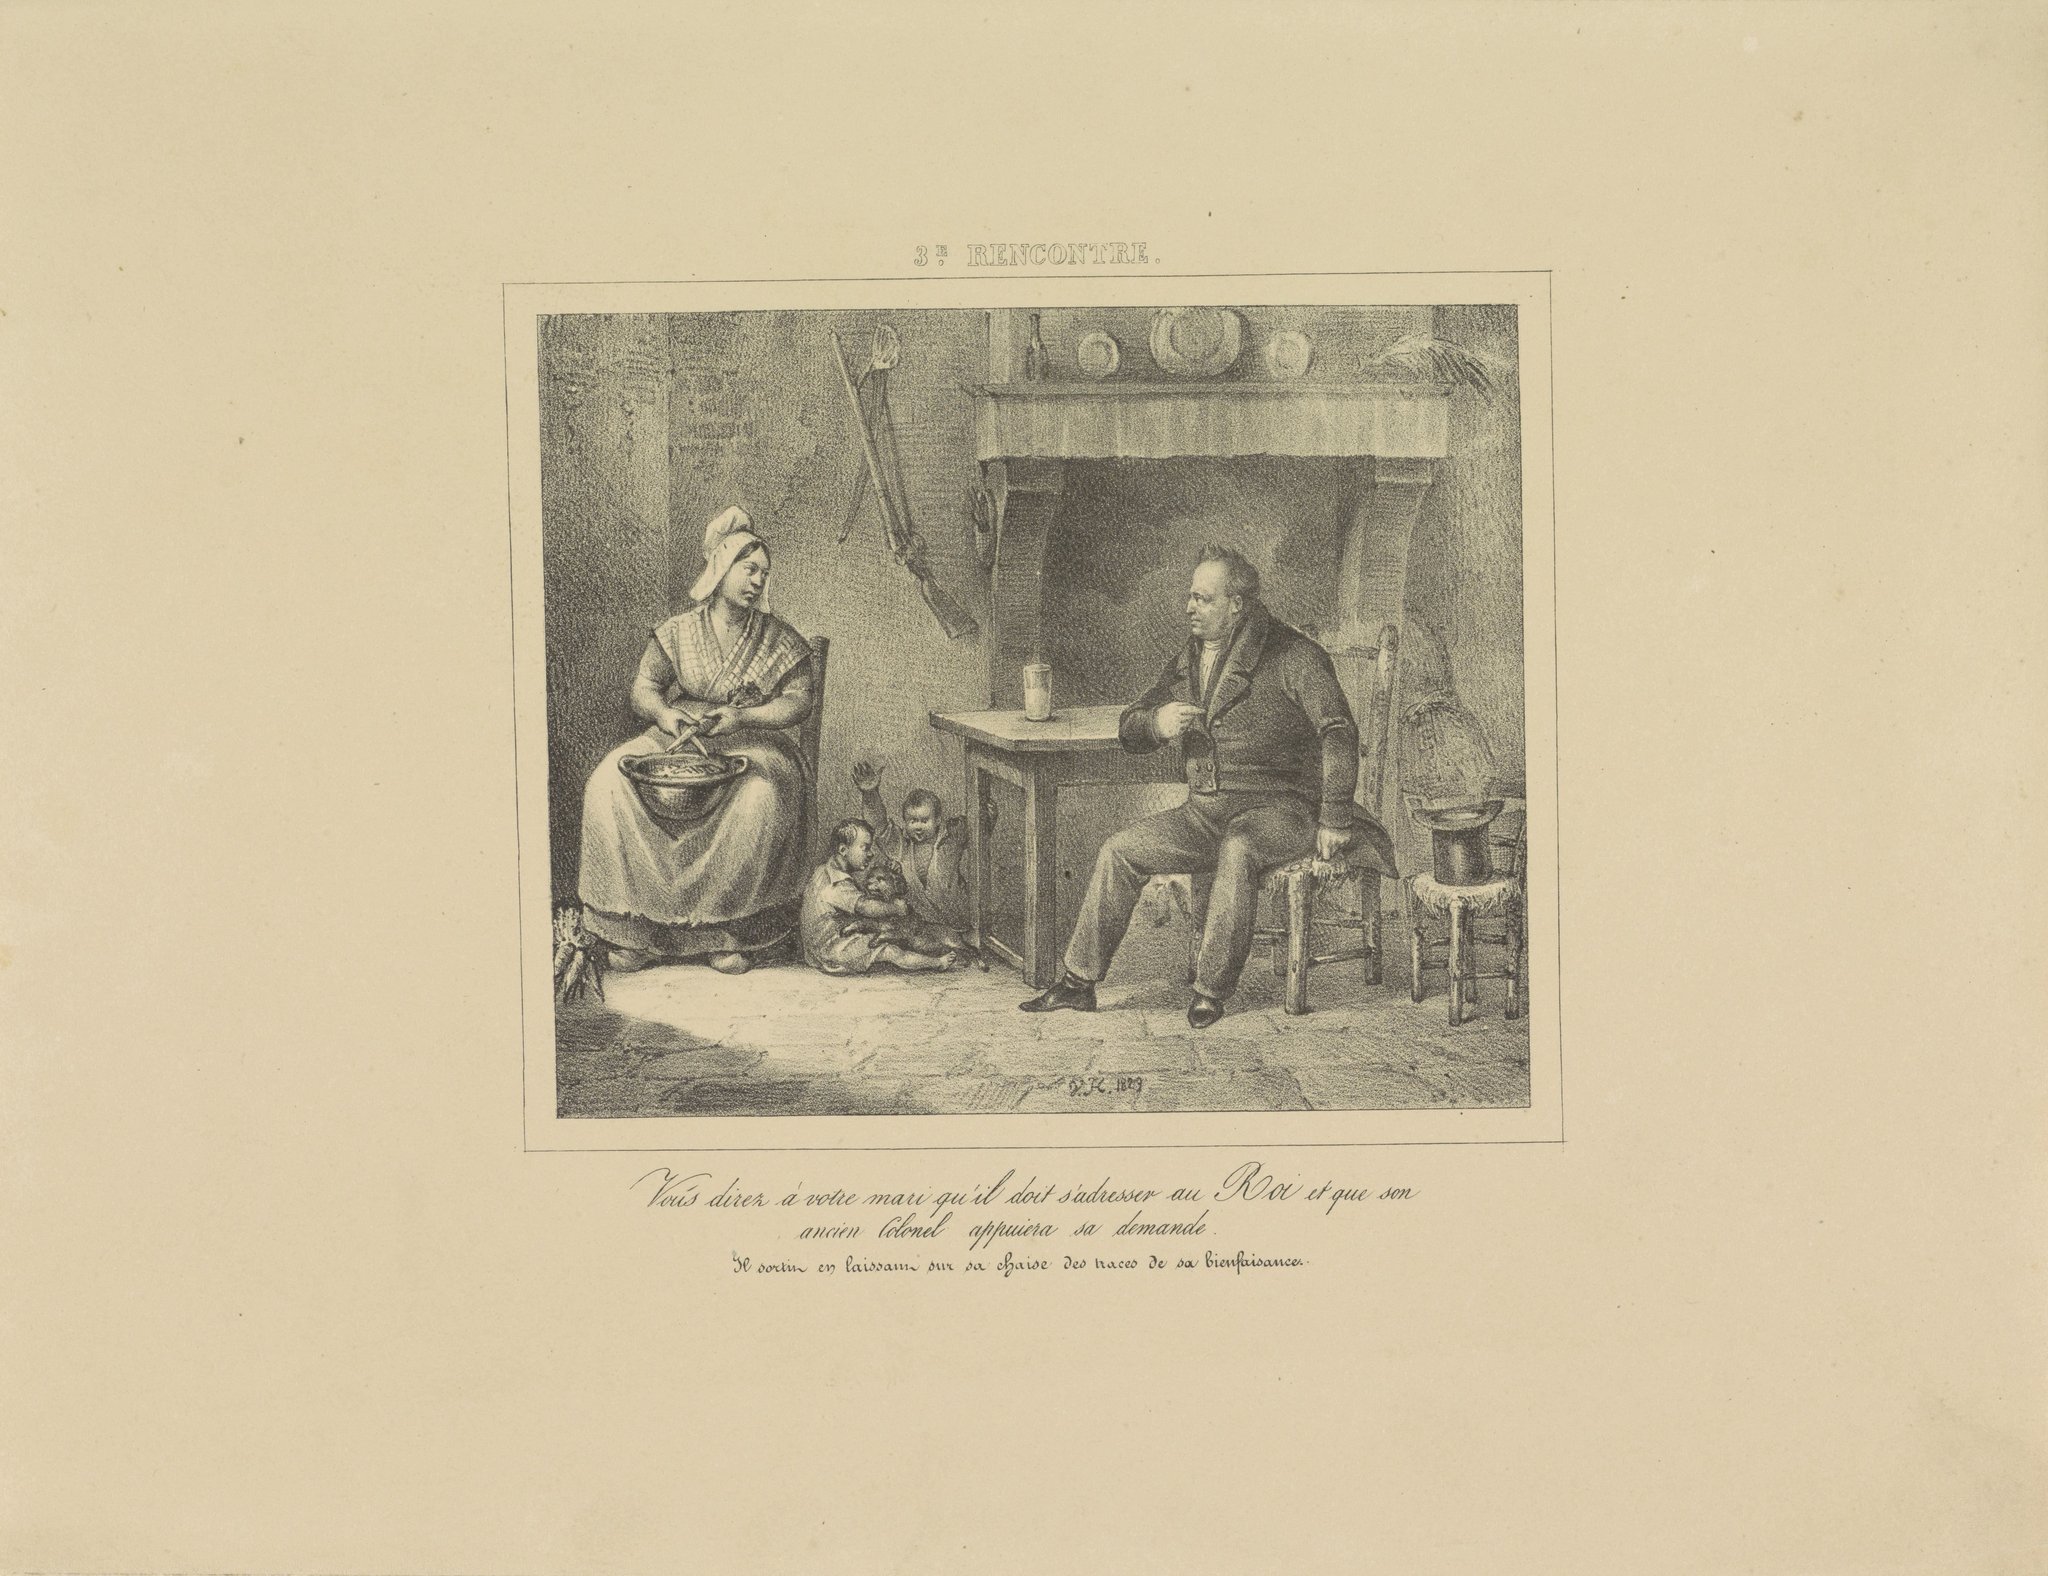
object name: print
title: Koning Willem I sprekend met een boerin, 1829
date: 1829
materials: paper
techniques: lithograph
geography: brussels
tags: berlin, william i of the netherlands, ruler in informal contact with his subjects, farmers - aa - female farmer, farmer's wife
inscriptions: collector's mark: Lugt 2228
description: De koning in een eenvoudige boerenwoning sprekend met de boerin. Ondertussen legt hij enkele geldstukken op zijn stoel. Met drieregelig onderschrift. Onderdeel van de serie van 24 platen met ontmoetingen met koning Willem I, verschenen onder de titel 'Les rencontres' in 1829-1830.